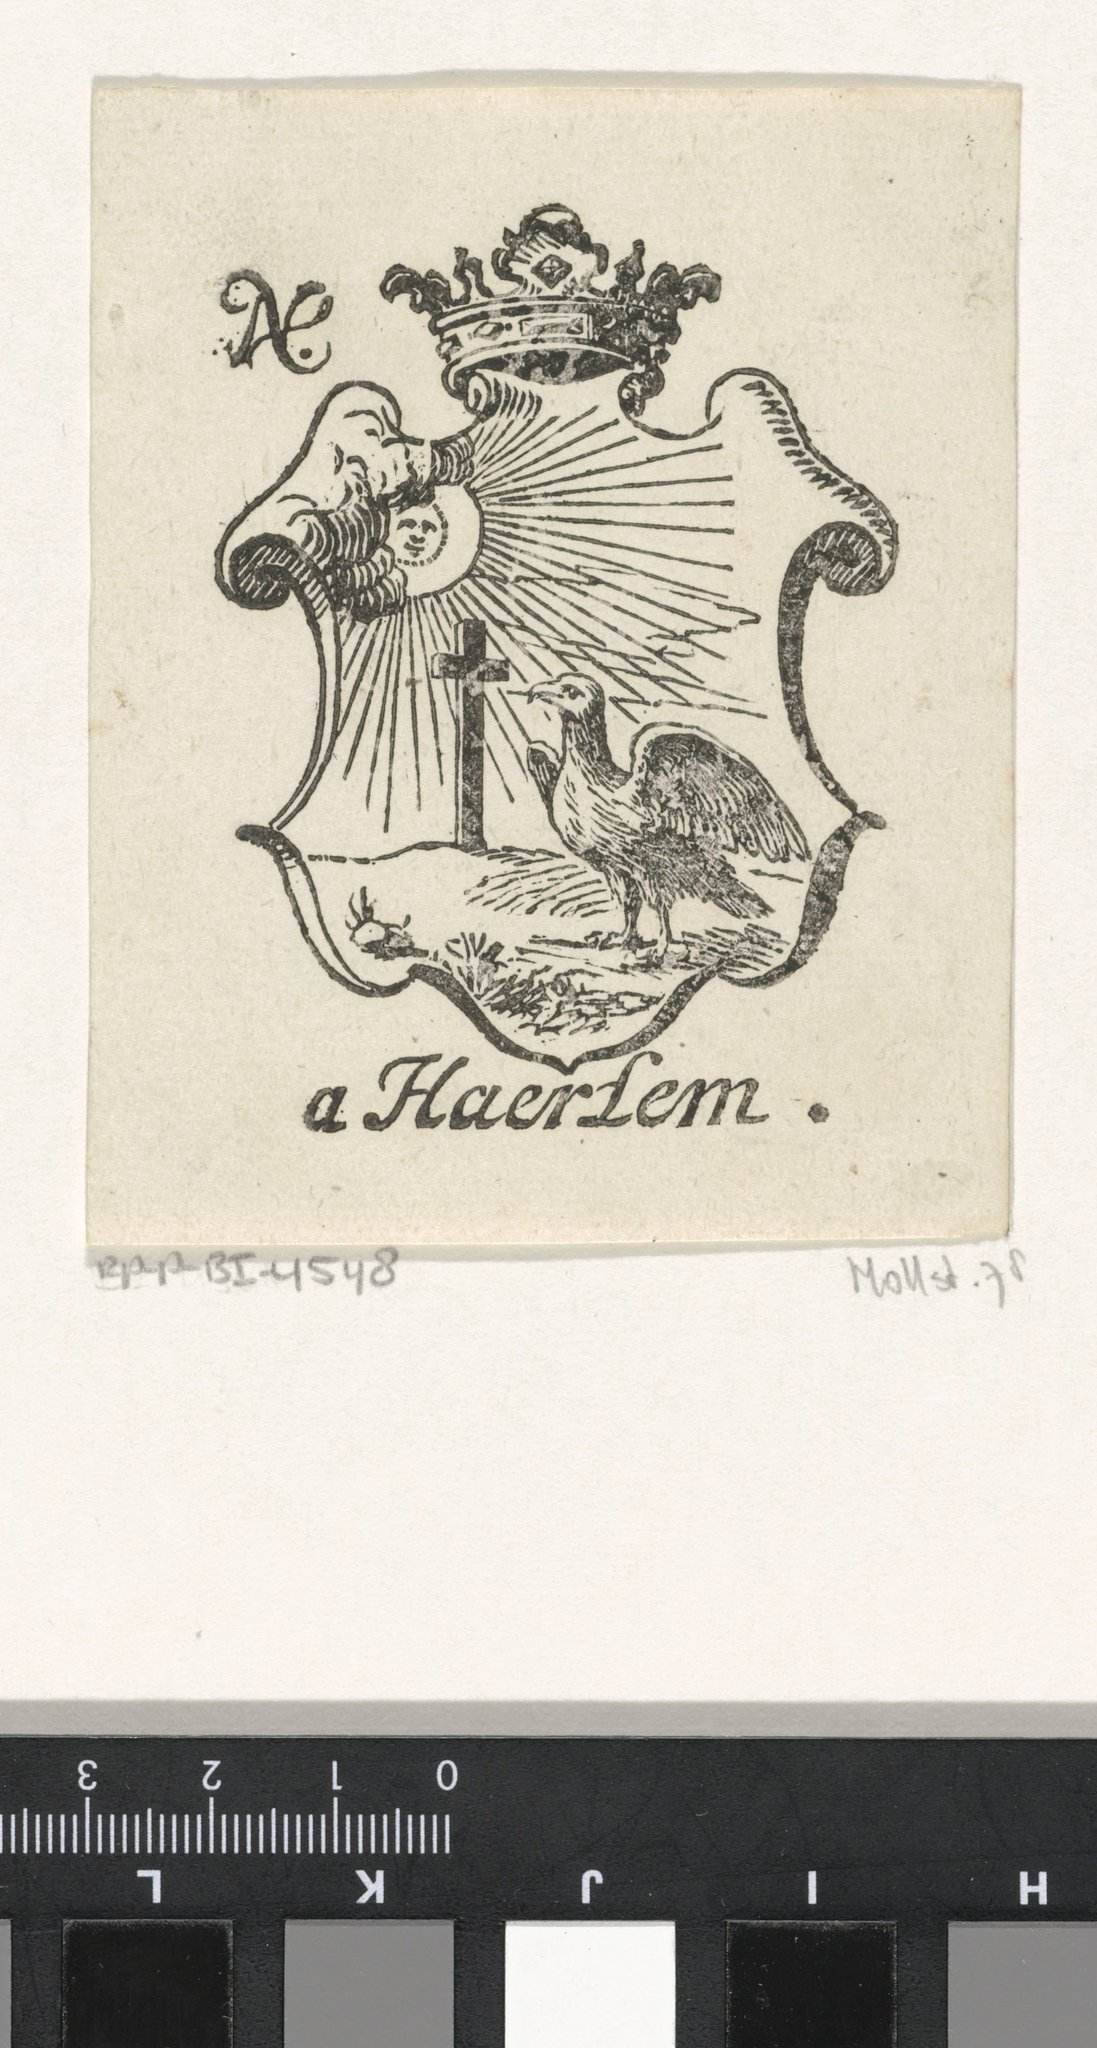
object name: handelsetiket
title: Handelsetiket met een adelaar, een kruis en de zon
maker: isaac vincentsz. van der vinne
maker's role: draughtsman, print maker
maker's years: 1665-1740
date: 1681-1740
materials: paper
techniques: woodcut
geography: haarlem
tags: predatory birds: eagle, cross as symbol of christ, sun represented as face, wheel, etc., vignette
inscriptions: collector's mark: Lugt 240